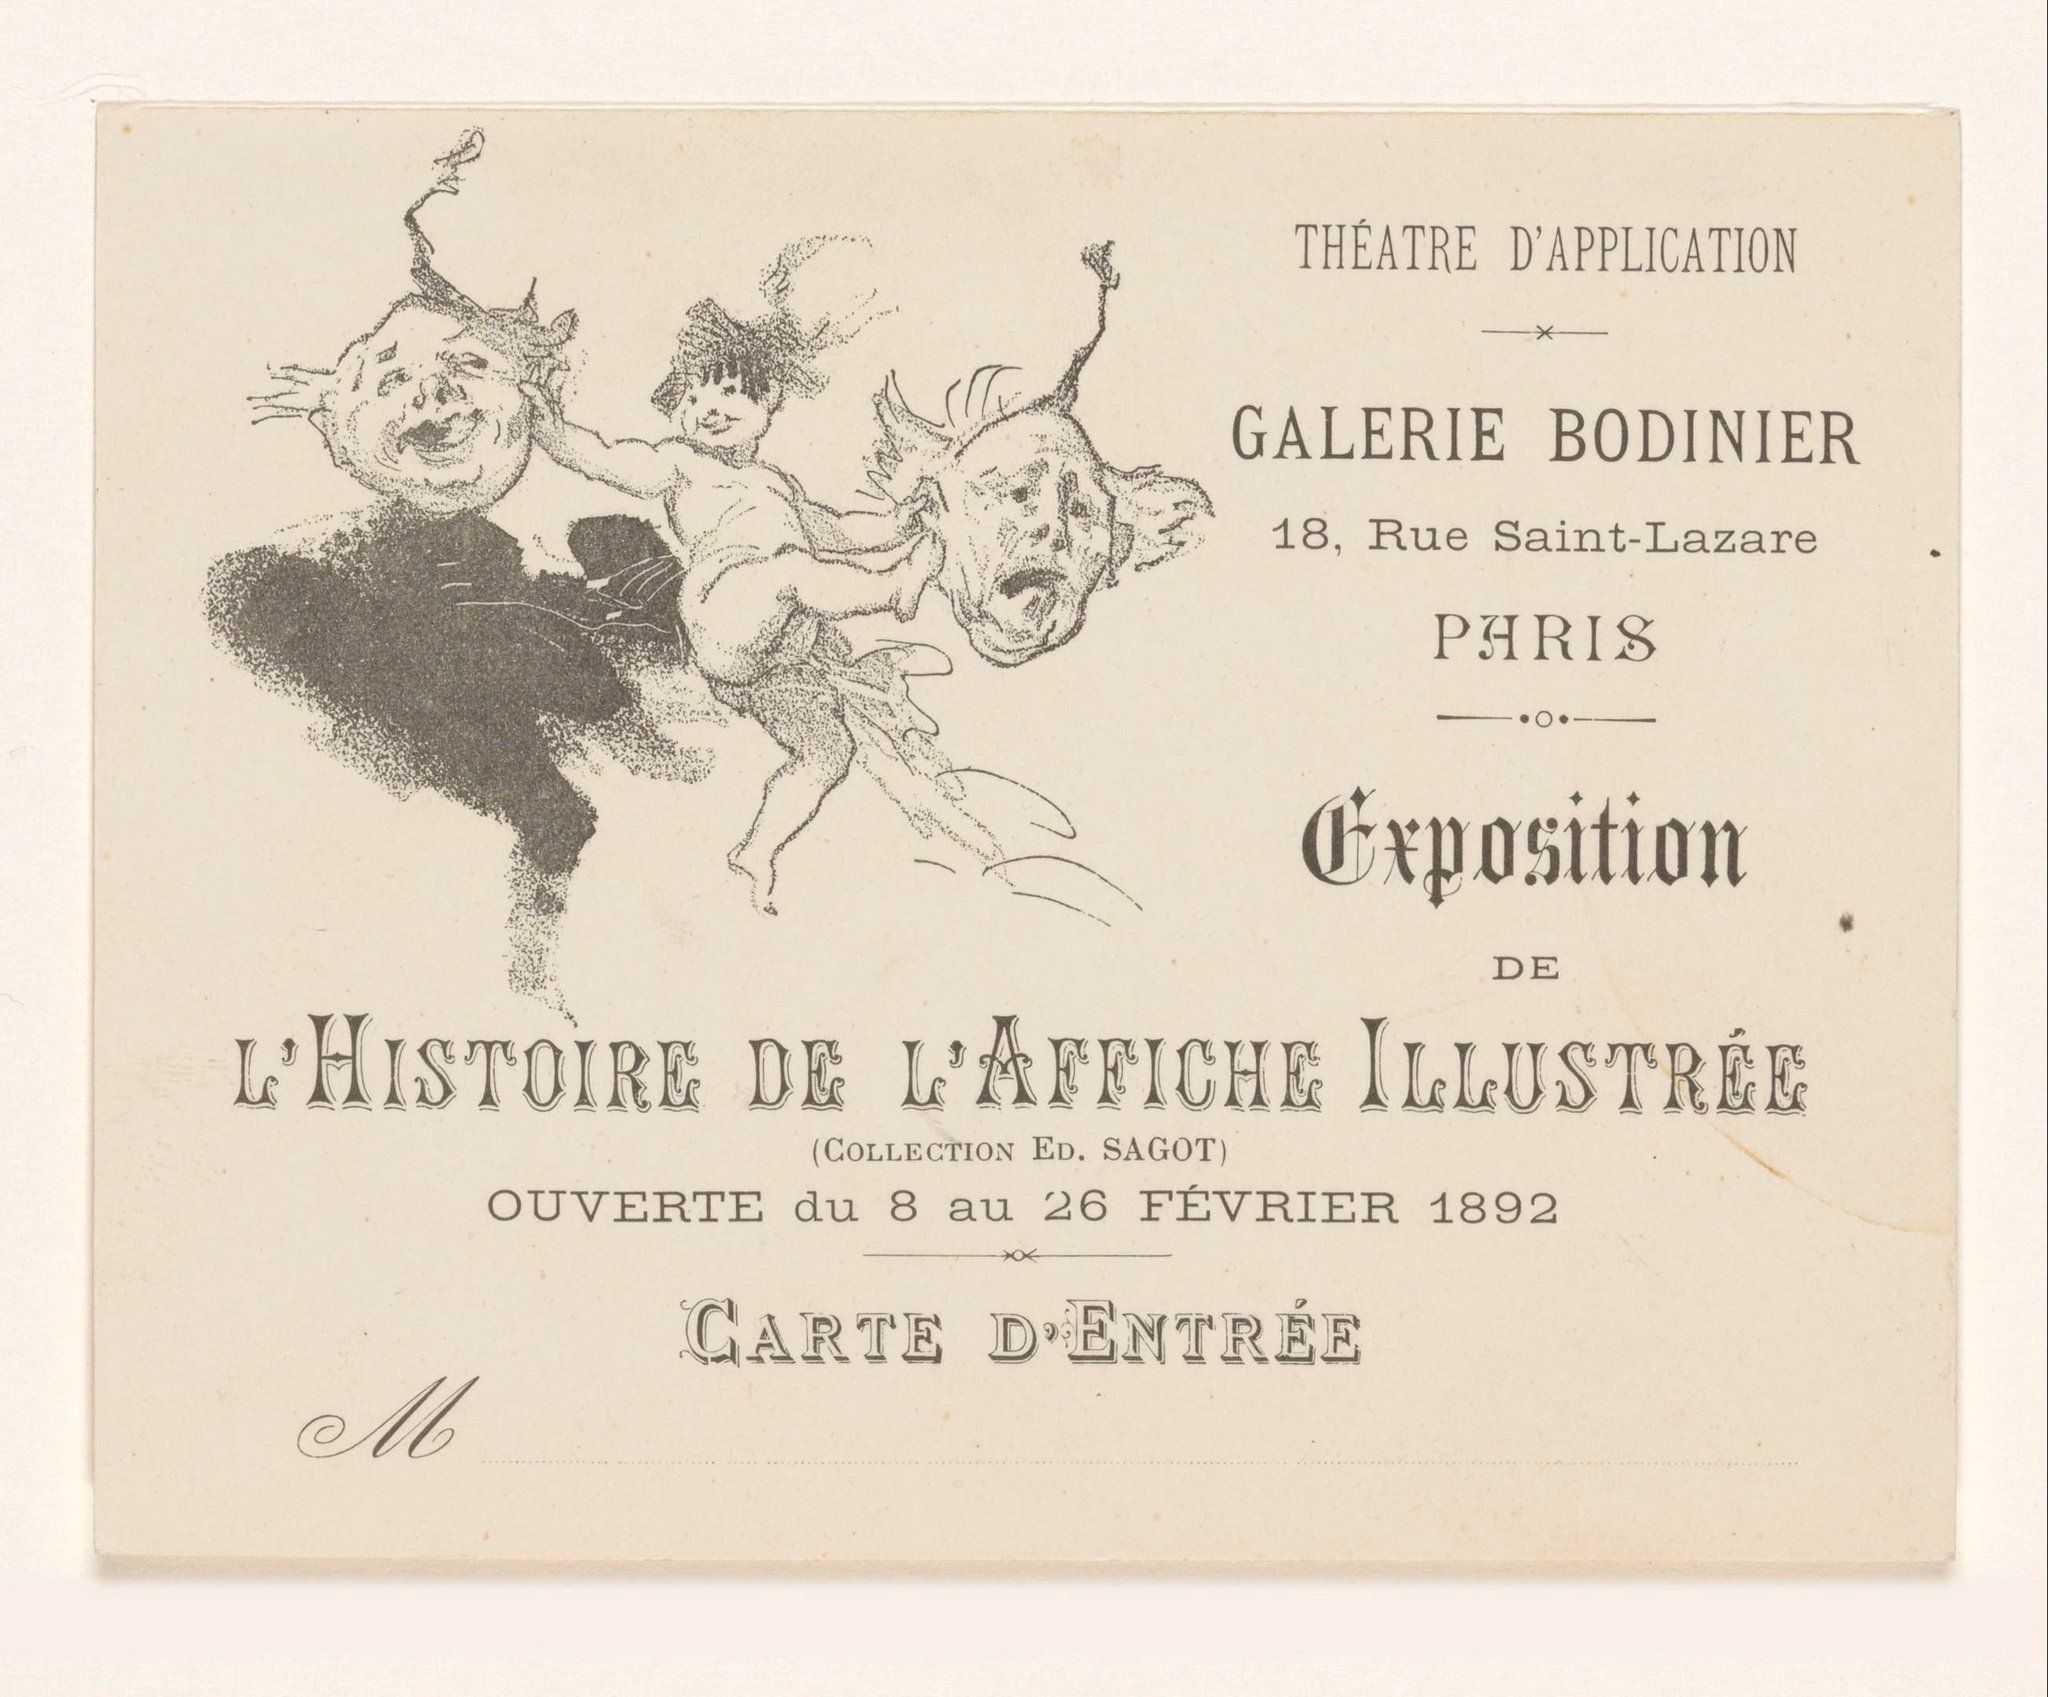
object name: print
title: Entreebewijs voor de Exposition de l'Histoire de l'Affiche Illustrée georganiseerd door Galerie Bodinier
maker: Anonymous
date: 1802-1892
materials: cardboard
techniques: lithograph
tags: mask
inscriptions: collector's mark: Lugt 2228, collector's mark: Lugt 4779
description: Een dansende naakte vrouw met twee maskers in haar handen.